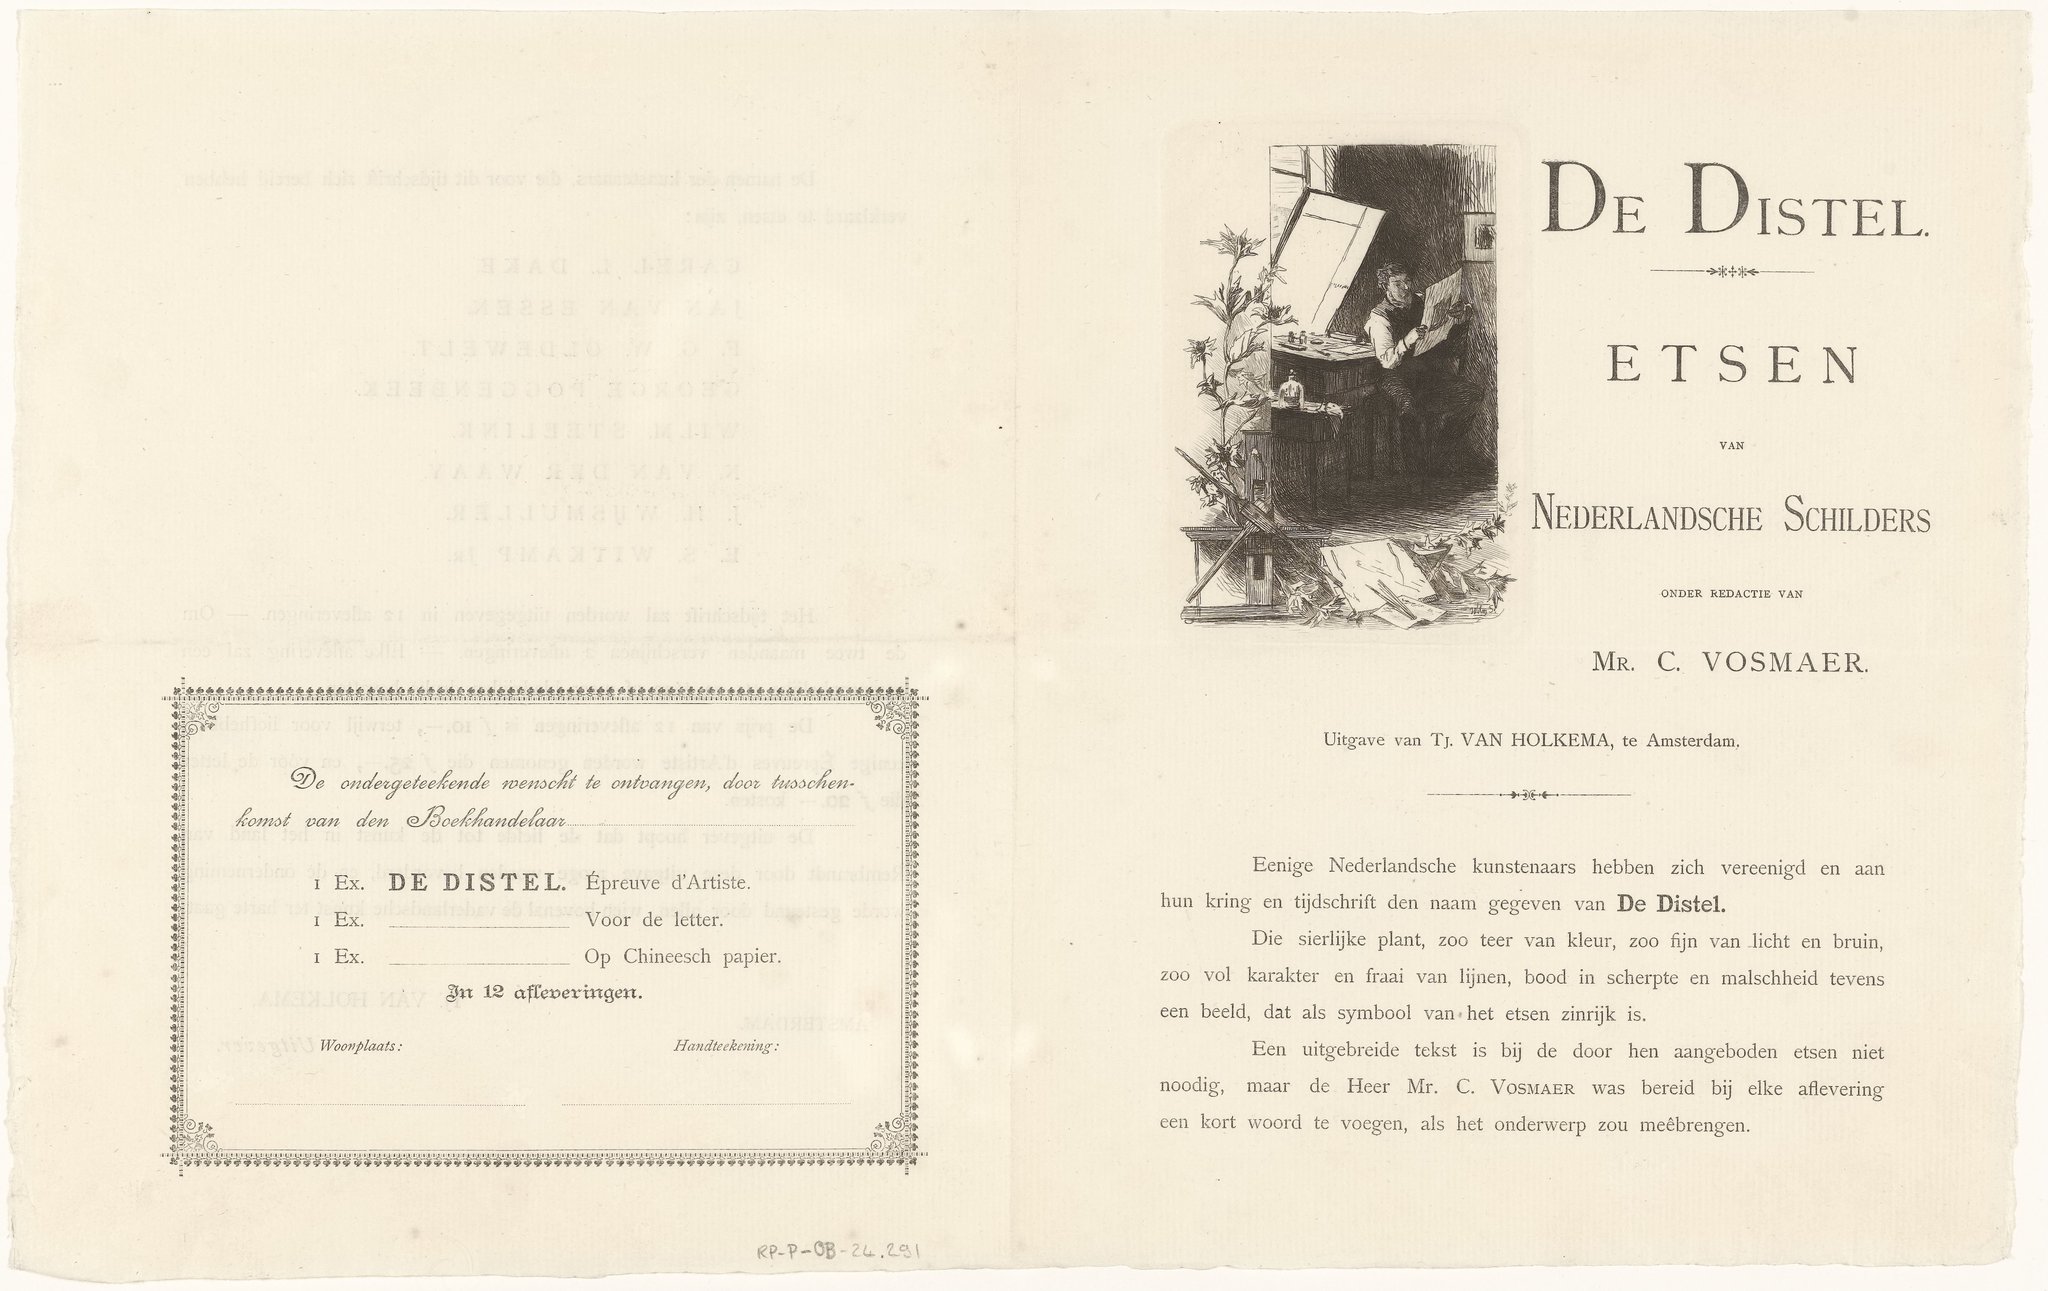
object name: print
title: Inschrijfbiljet en intekenlijst voor: De distel. Etsen van Nederlandsche schilders onder redactie van Mr. C. Vosmaer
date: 1885-1886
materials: paper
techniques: etching, letterpress printing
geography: amsterdam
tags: printing press, print, e.g.: engraving, etching, lithograph (+ in workshop or studio)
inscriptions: collector's mark: Lugt 2228